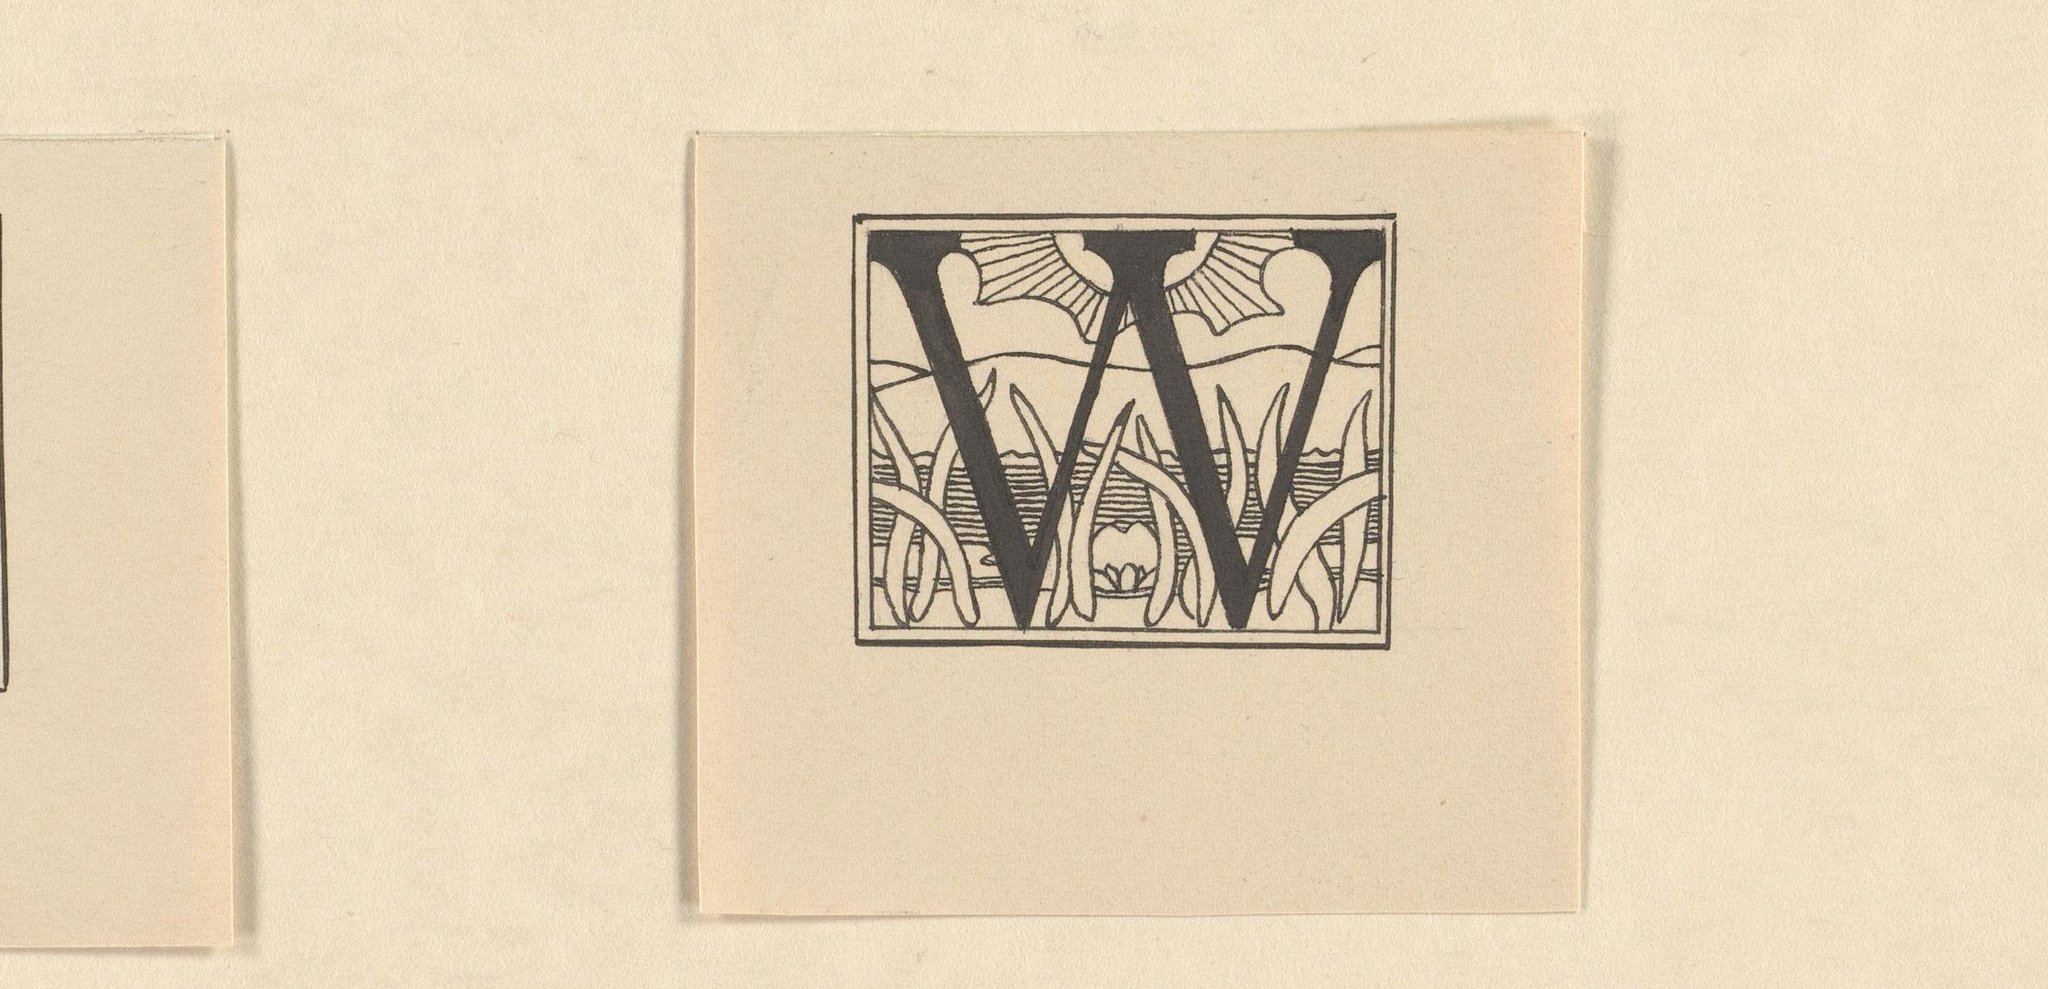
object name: drawing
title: Gedecoreerde initiaal W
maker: edzard koning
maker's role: draughtsman, print maker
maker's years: 1869-1954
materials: ink, paper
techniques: brush, pen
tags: plants; vegetation, initial, sun as celestial body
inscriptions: collector's mark: Lugt 2228, inscription: ‘hoofdst. III’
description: Mogelijk een ontwerp voor: Eeden, Frederik van. De kleine Johannes. Den Haag: Mouton & Co., 1898. Niet gebruikt in de definitieve uitgave.